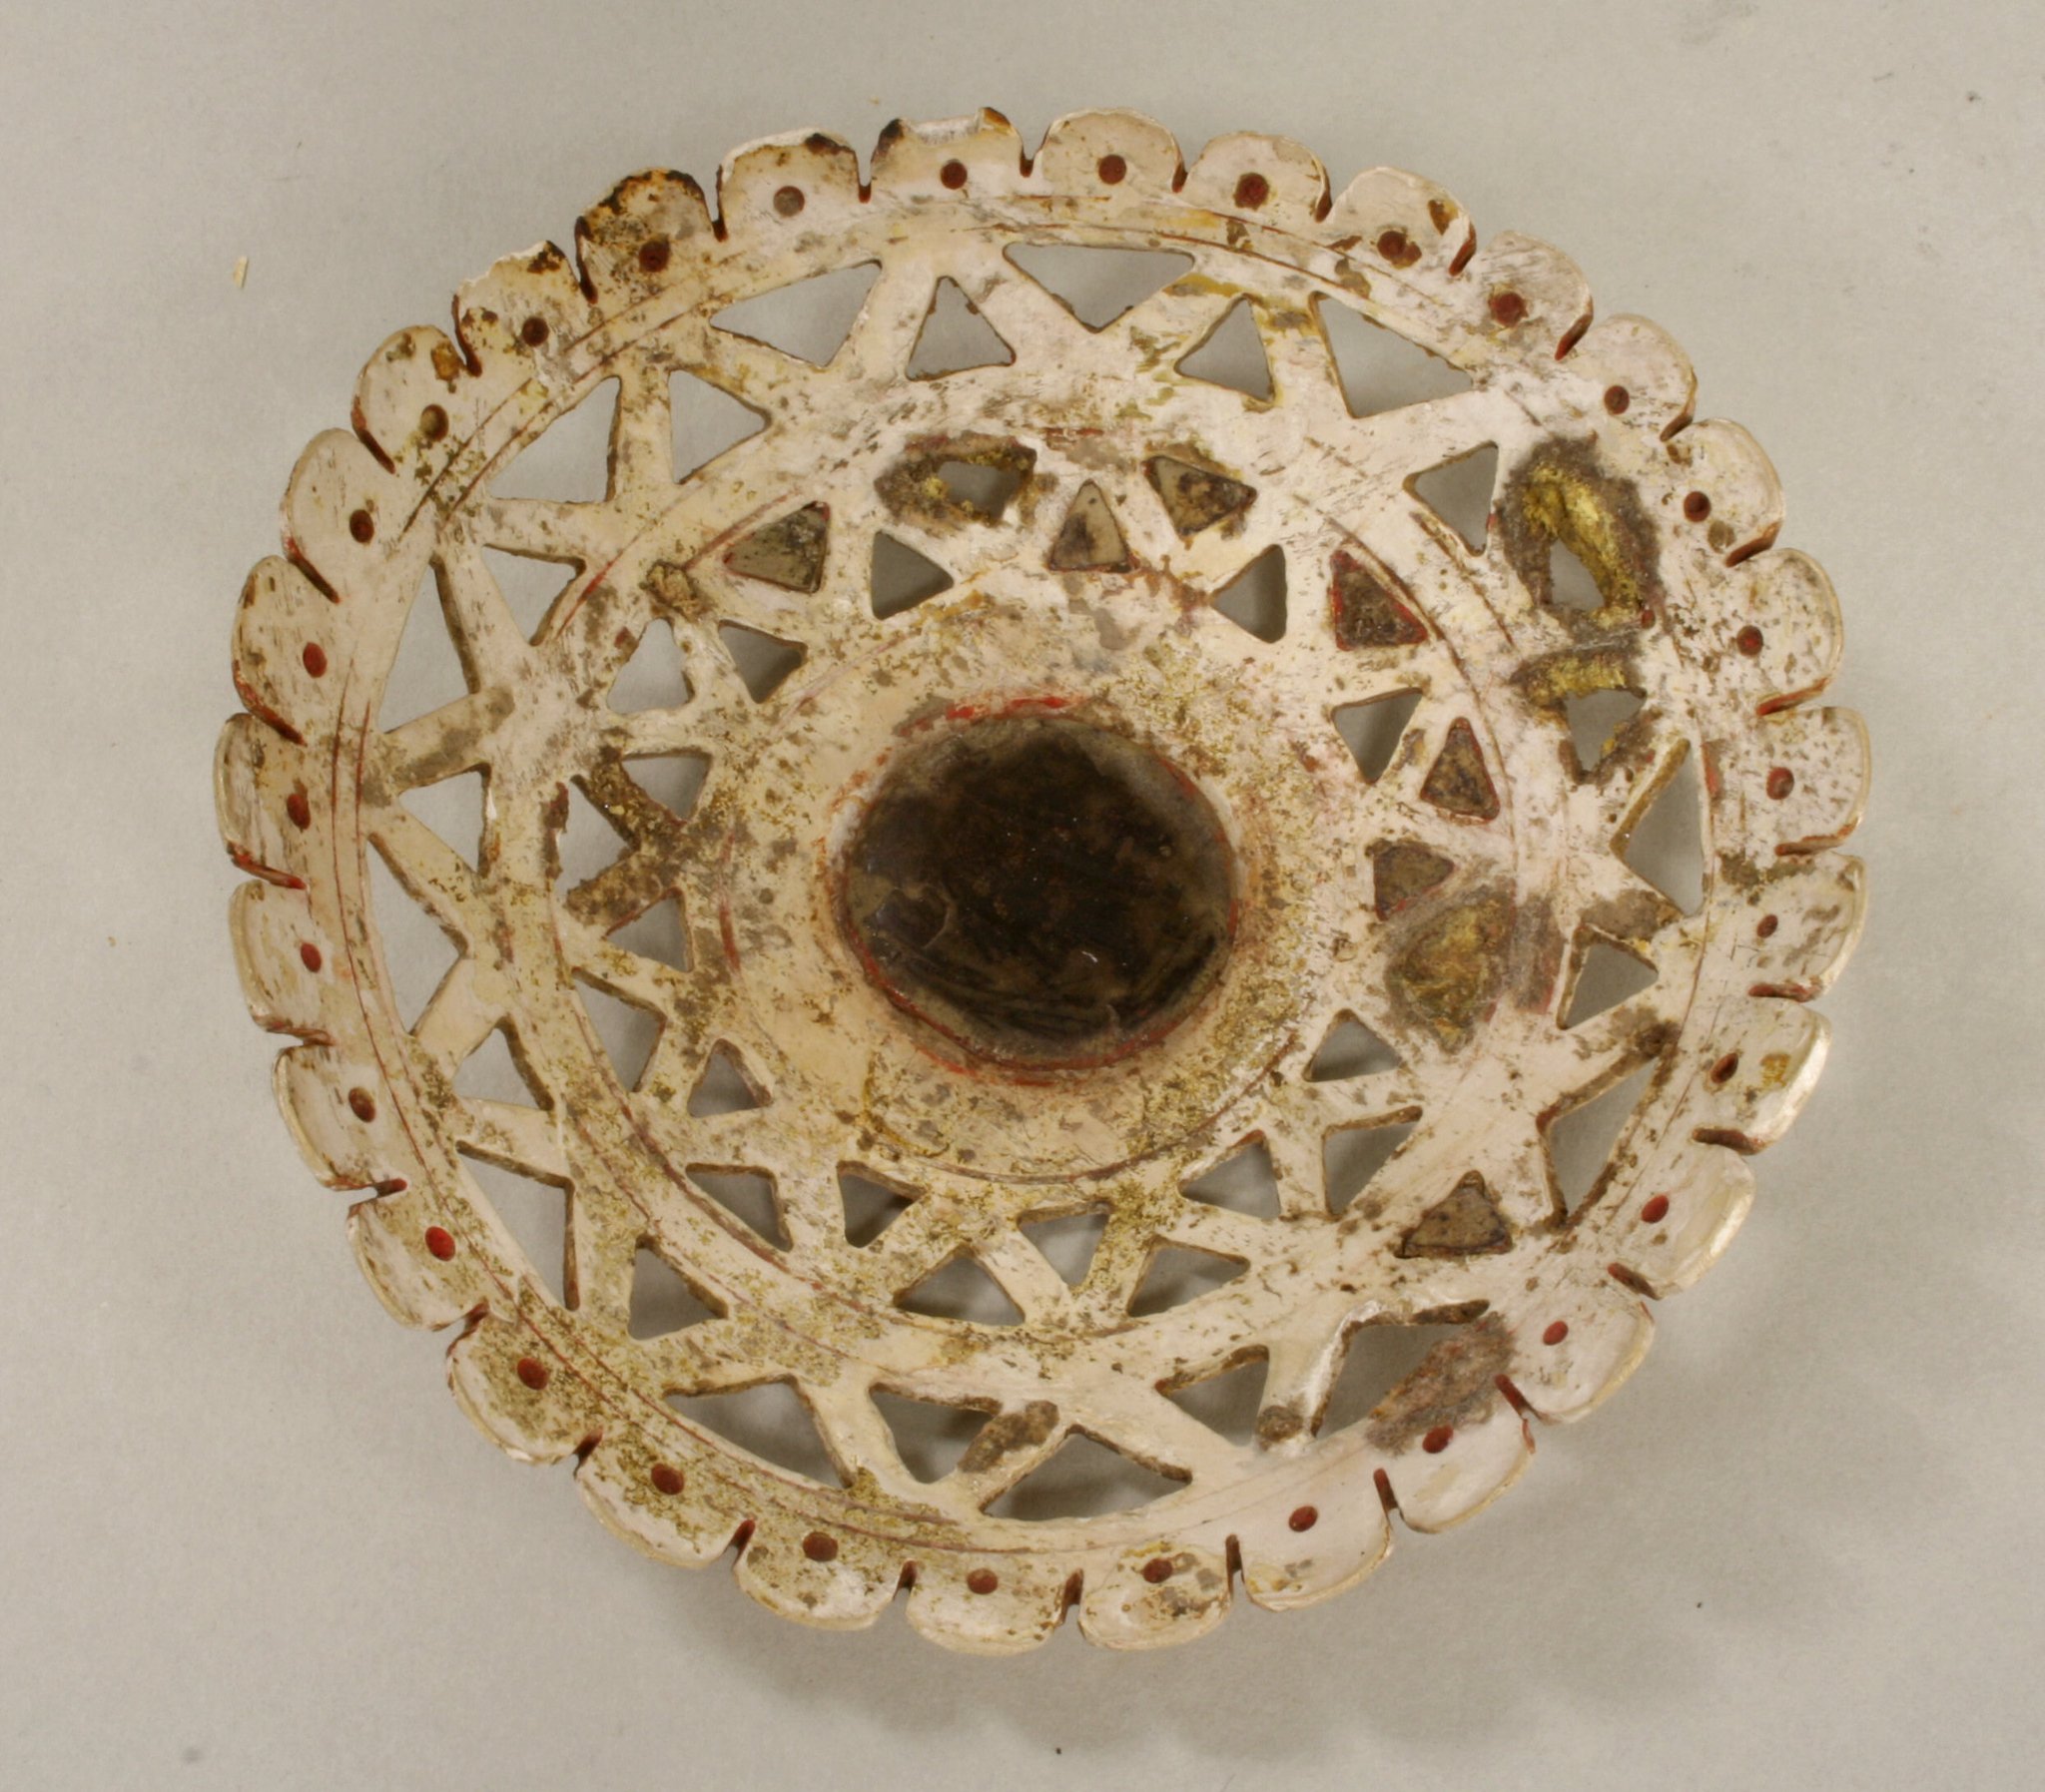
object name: earflare frontal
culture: huastec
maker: huastec artist(s)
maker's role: artist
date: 900-1300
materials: iron, shell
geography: mexico